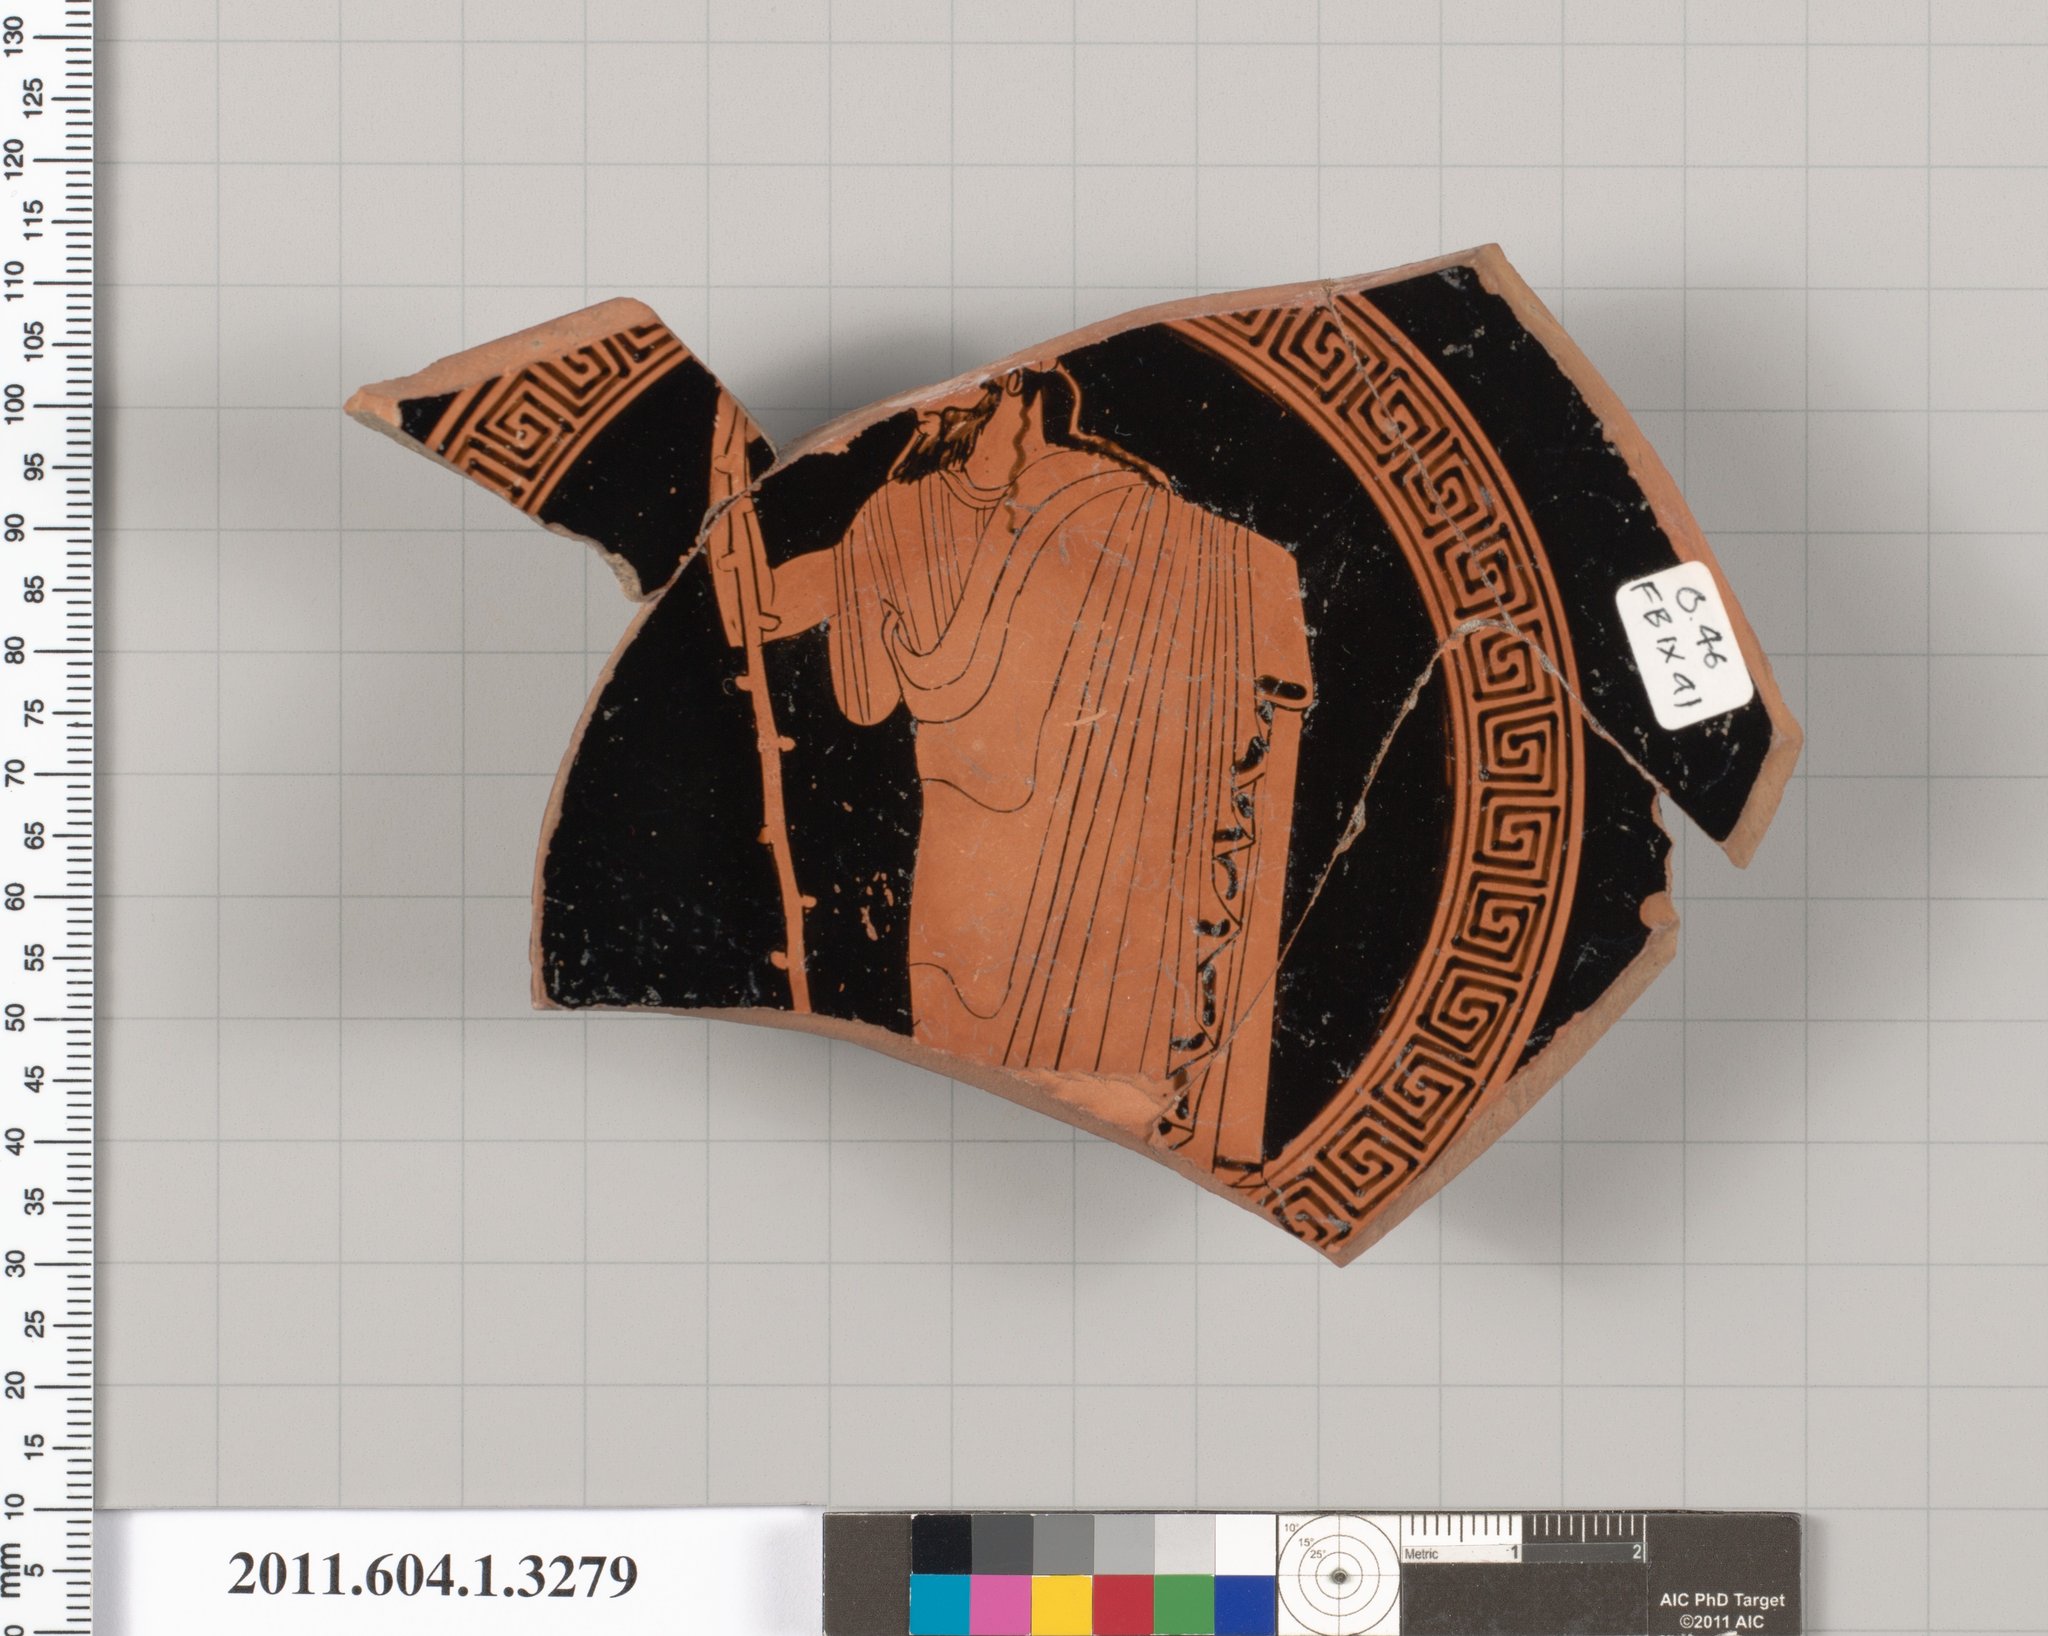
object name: kylix fragment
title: Terracotta fragment of a kylix (drinking cup)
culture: greek, attic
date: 470-460 BCE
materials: terracotta